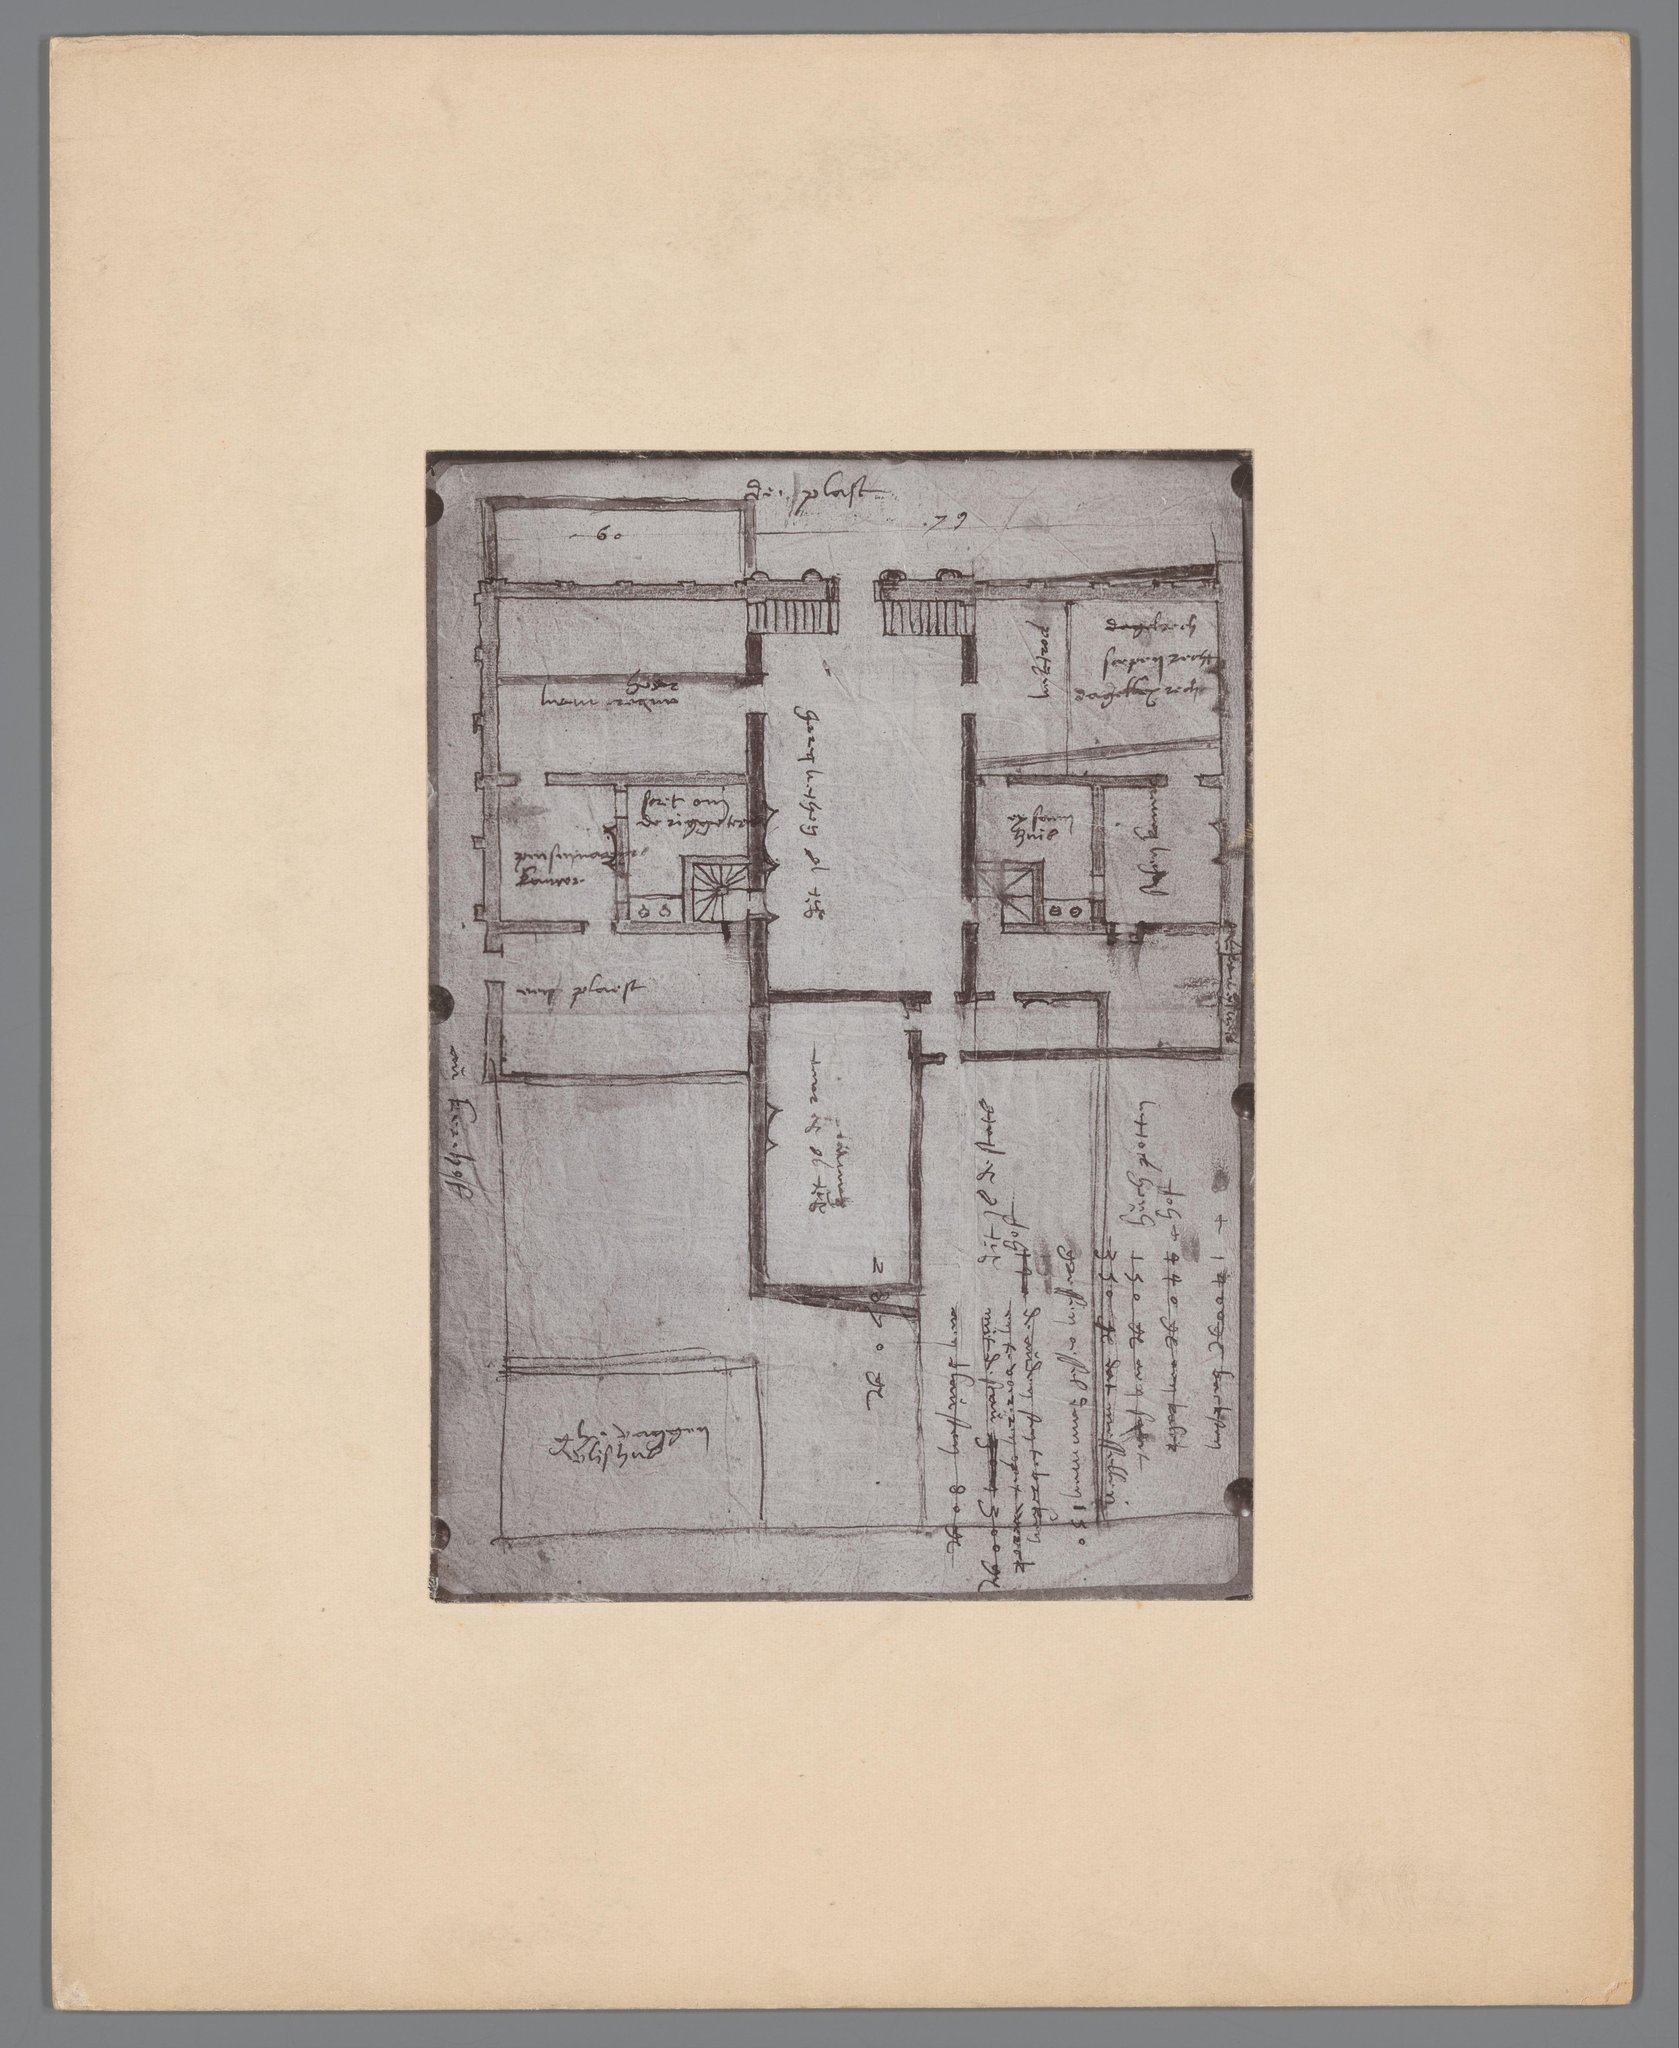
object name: reproduction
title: Fotoreproductie van een plattegrond van het stadhuis van Utrecht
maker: Anonymous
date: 1880-1910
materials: cardboard, photographic support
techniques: collodion silver print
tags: townhall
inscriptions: annotation: ‘Stadhuis Utrecht’